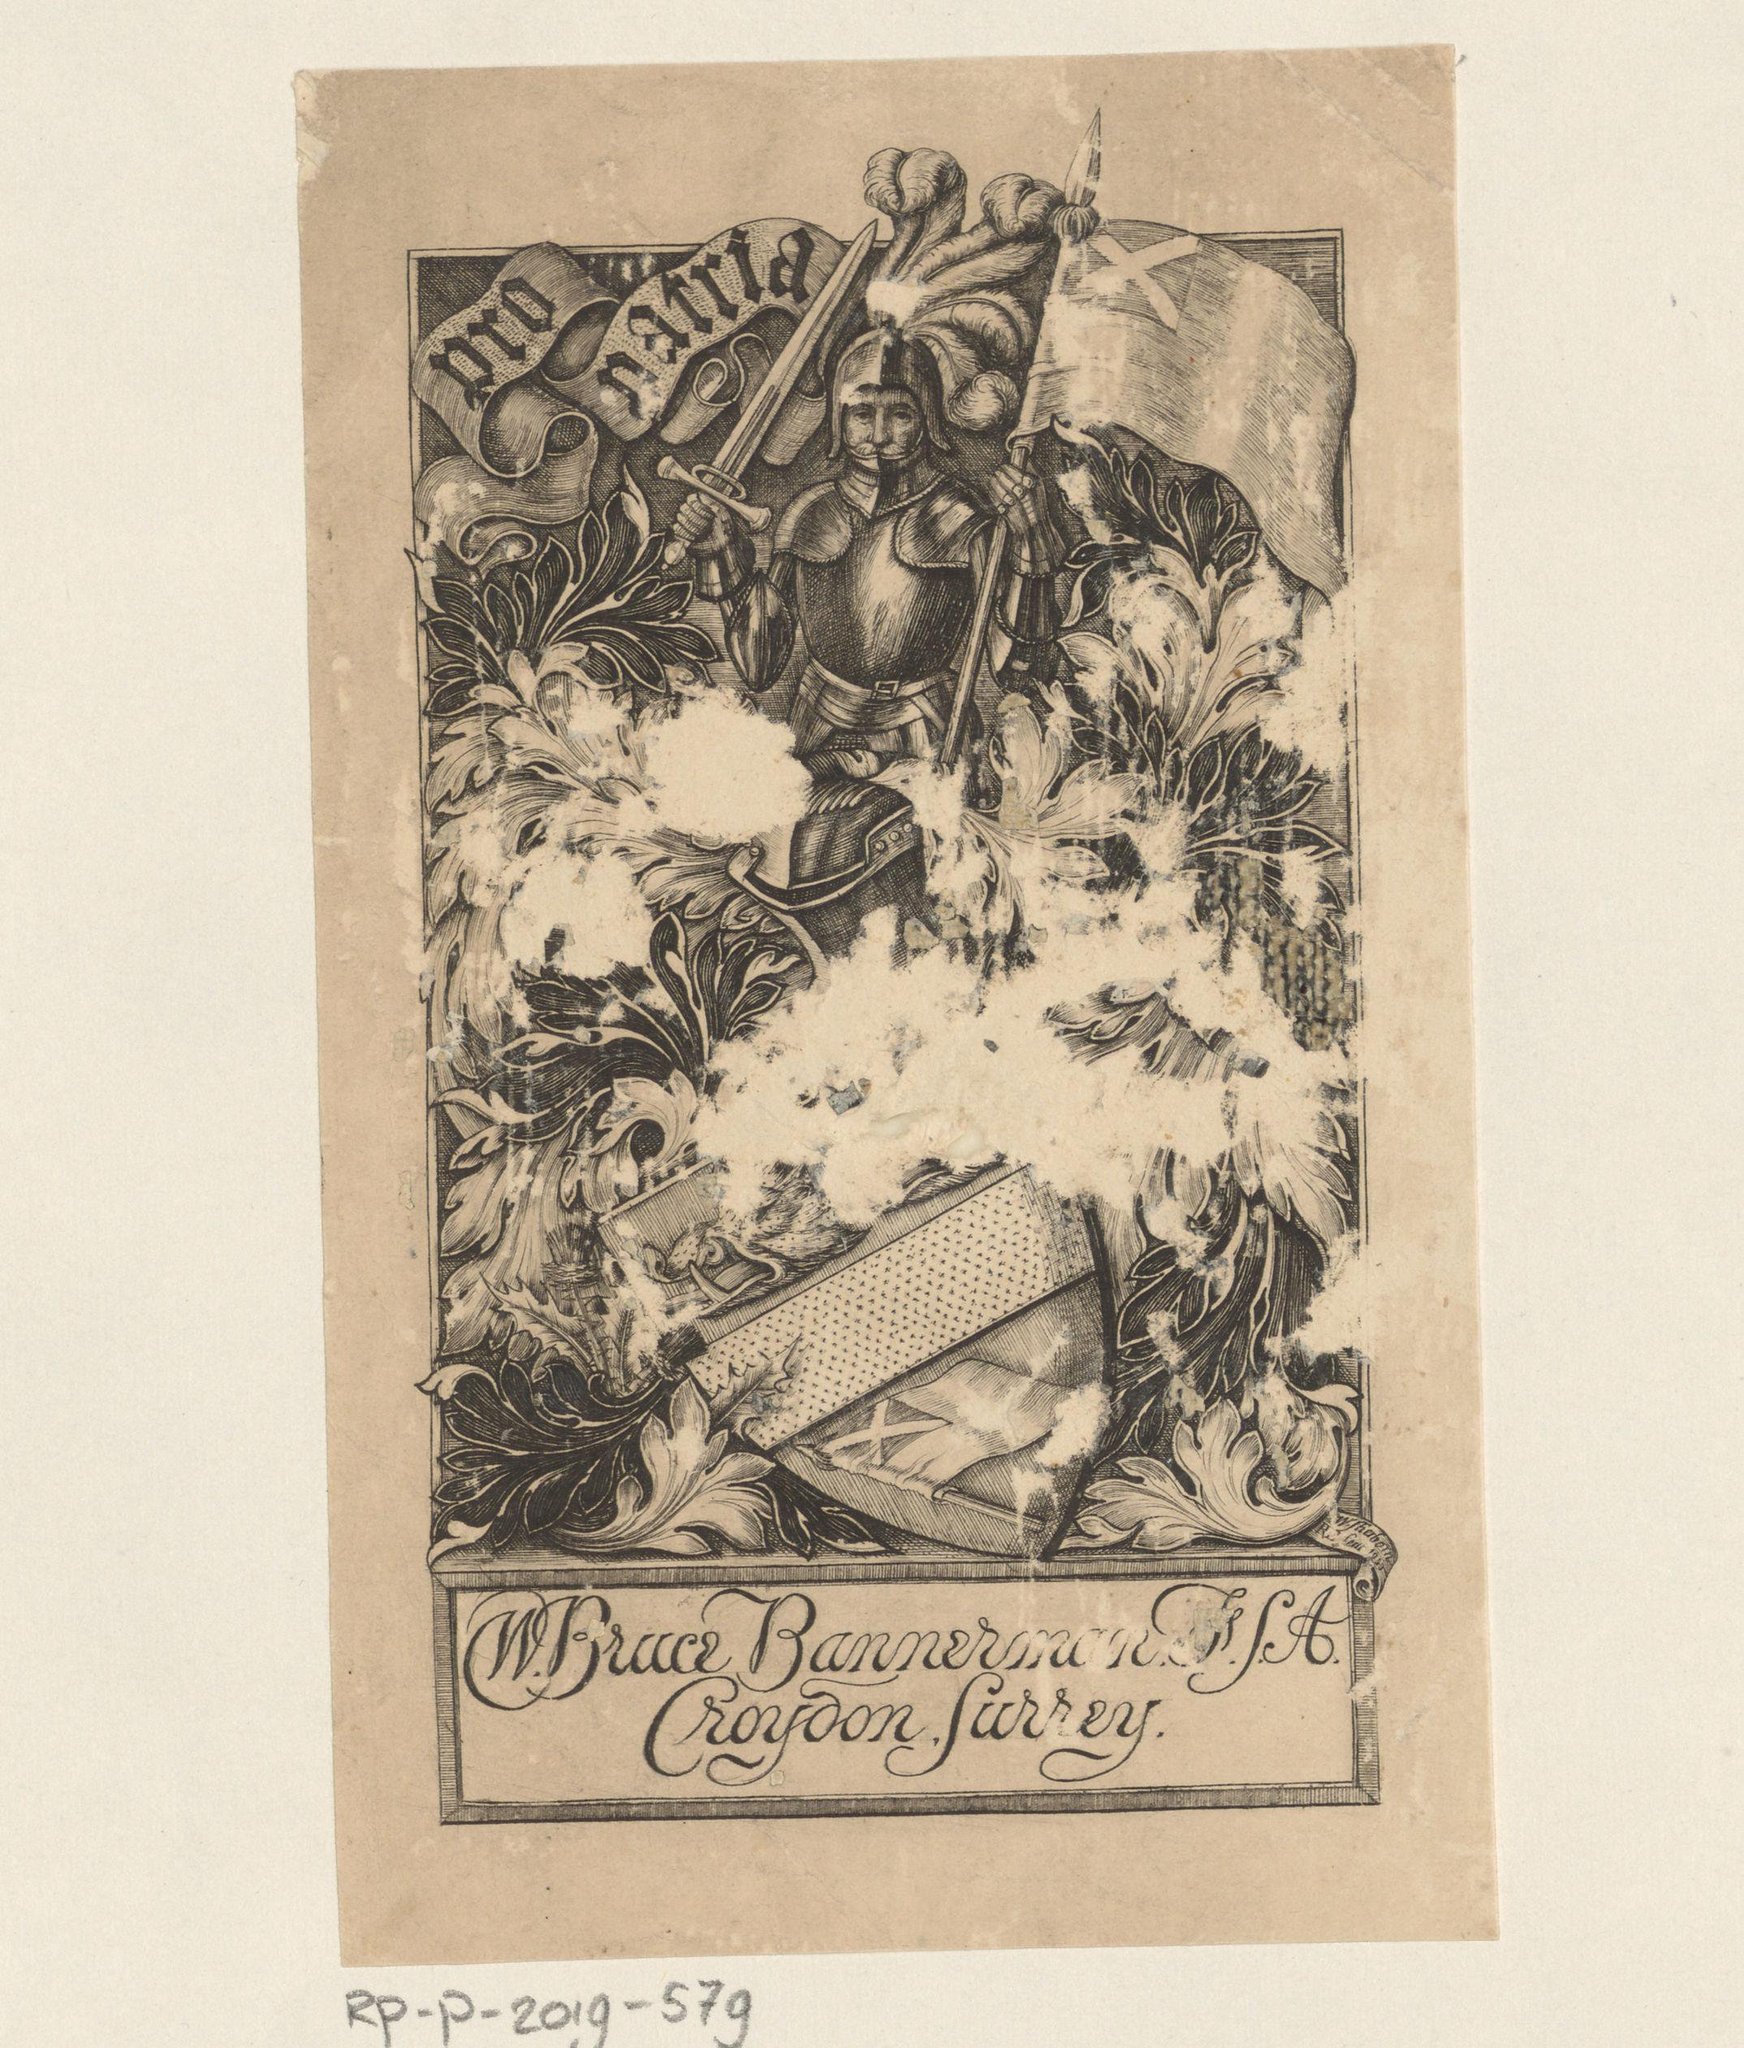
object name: bookplate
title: Pro patria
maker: charles william sherborn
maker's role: print maker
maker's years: 1831-1912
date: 1900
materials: paper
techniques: engraving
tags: knight, armorial bearing, heraldry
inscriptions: date